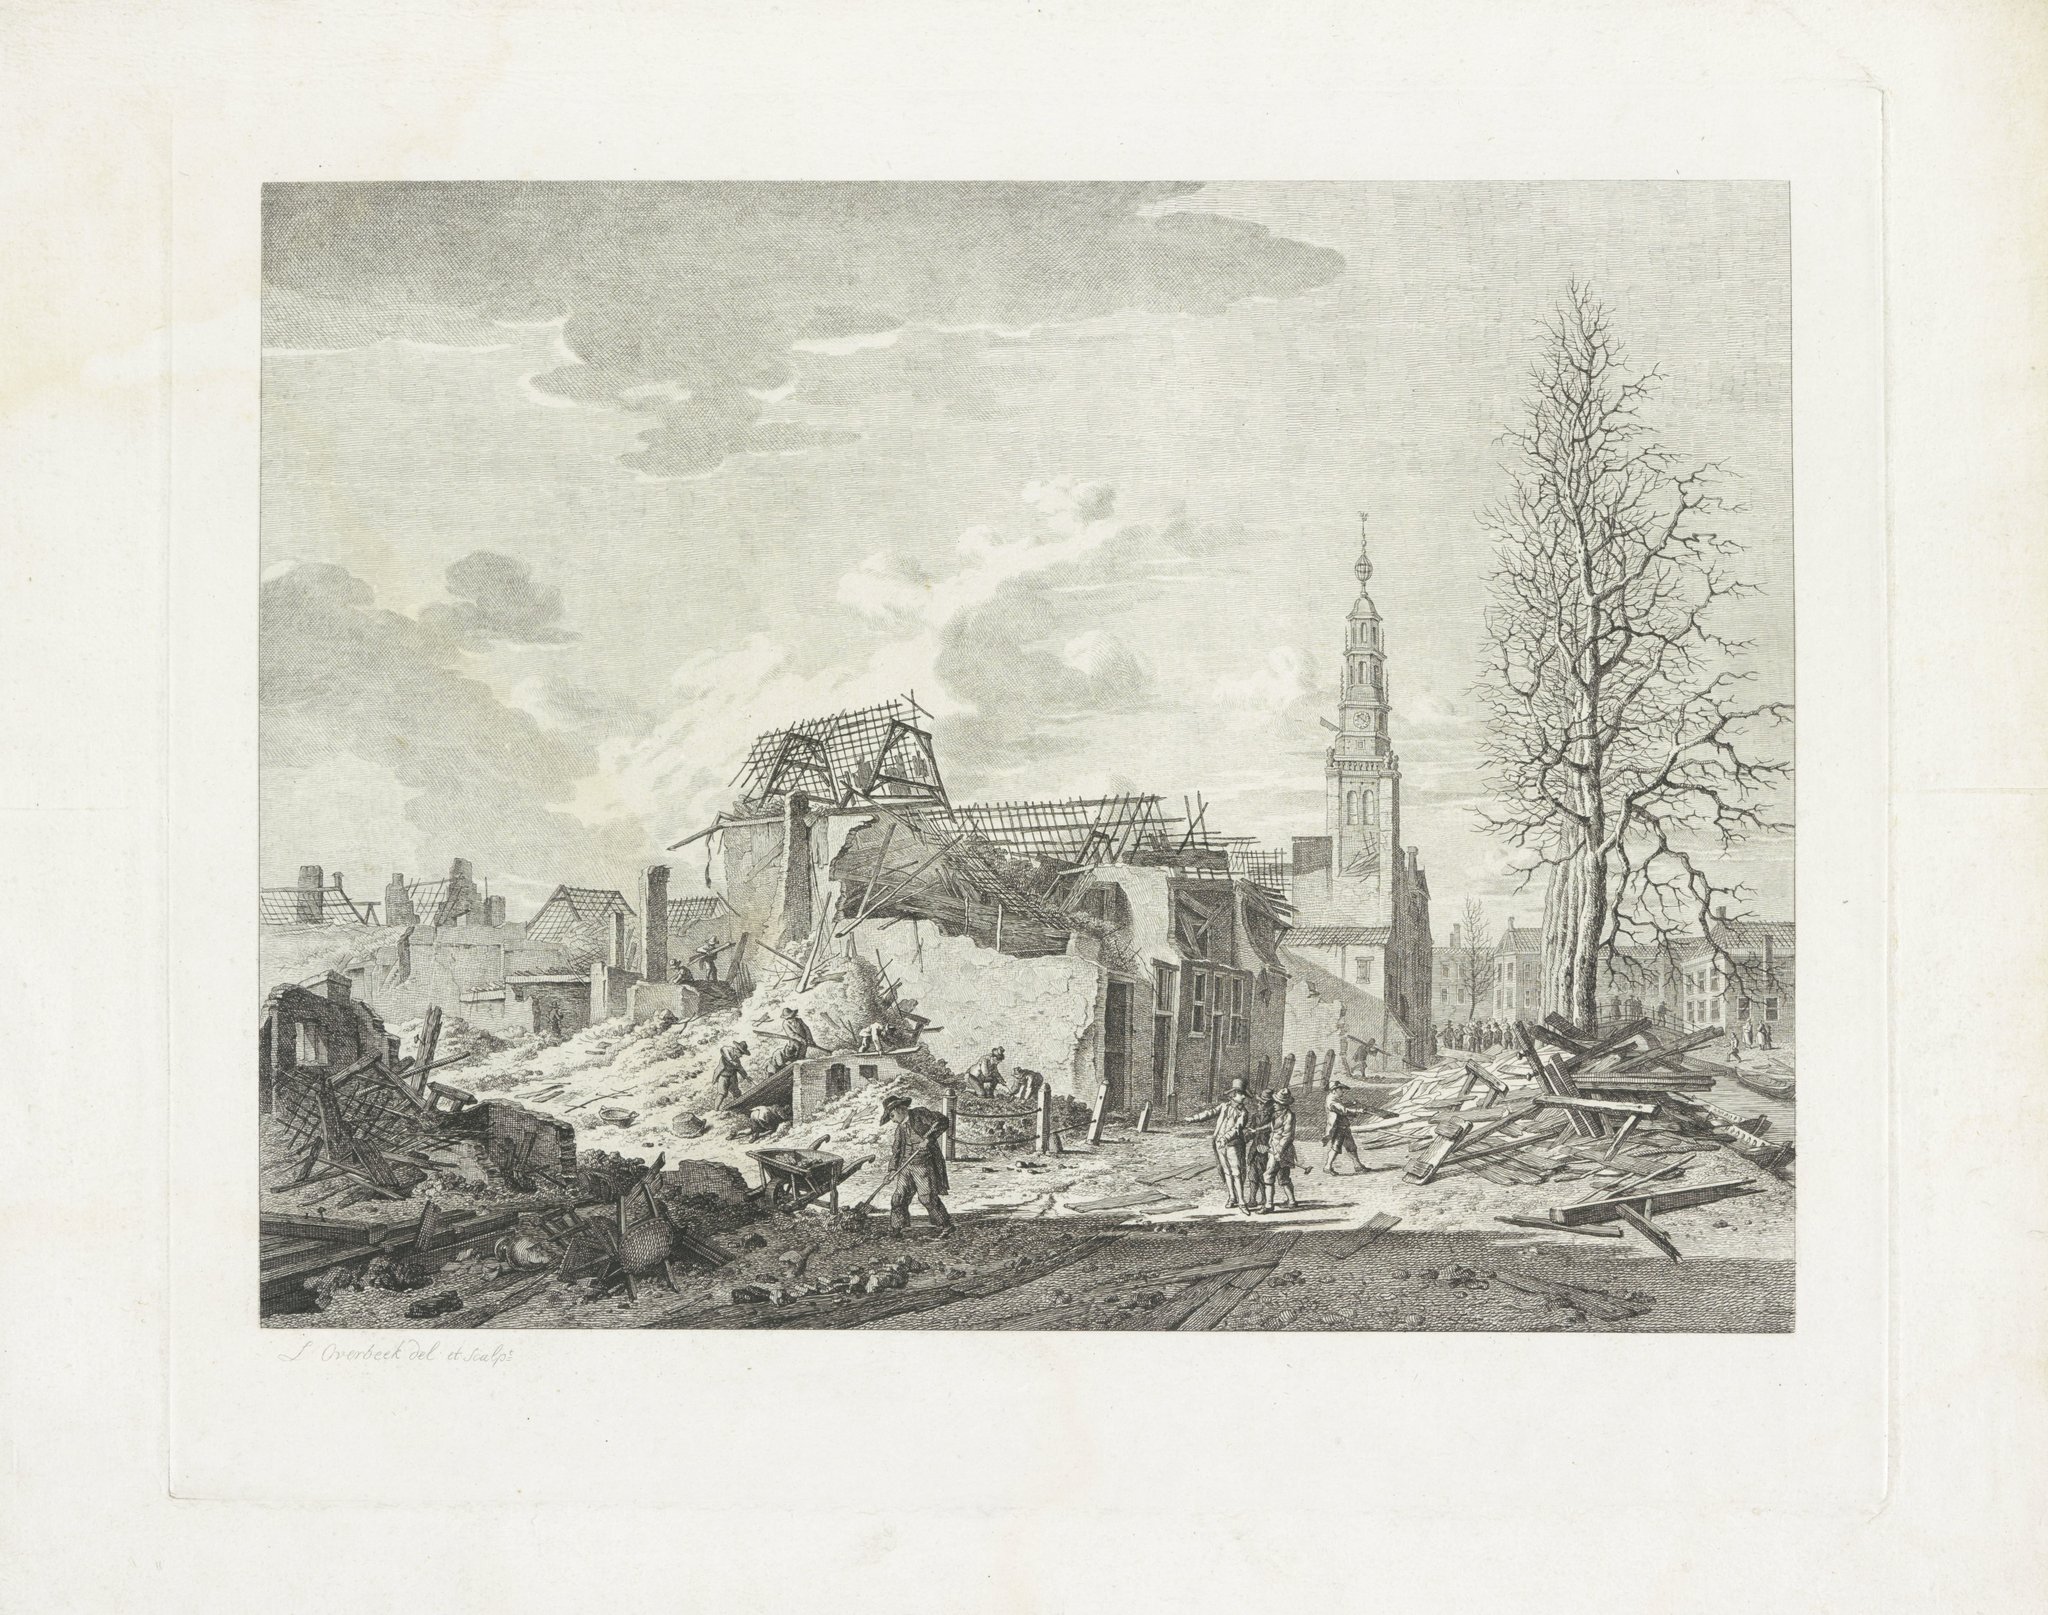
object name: print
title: Ruïnes op het Steenschuur (noordzijde) na de Leidse buskruitramp, 1807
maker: leendert overbeek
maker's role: draughtsman, painter, print maker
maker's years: 1752-1815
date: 1807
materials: paper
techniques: engraving, etching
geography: leiden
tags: gunpowder disaster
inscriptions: collector's mark: Lugt 2228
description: Opruimwerkzaamheden bij de verwoeste gebouwen aan de noordzijde van het Steenschuur te Leiden na de buskruitramp op 12 januari 1807, middenrechts de Saaihal. Zie ook de pendant.